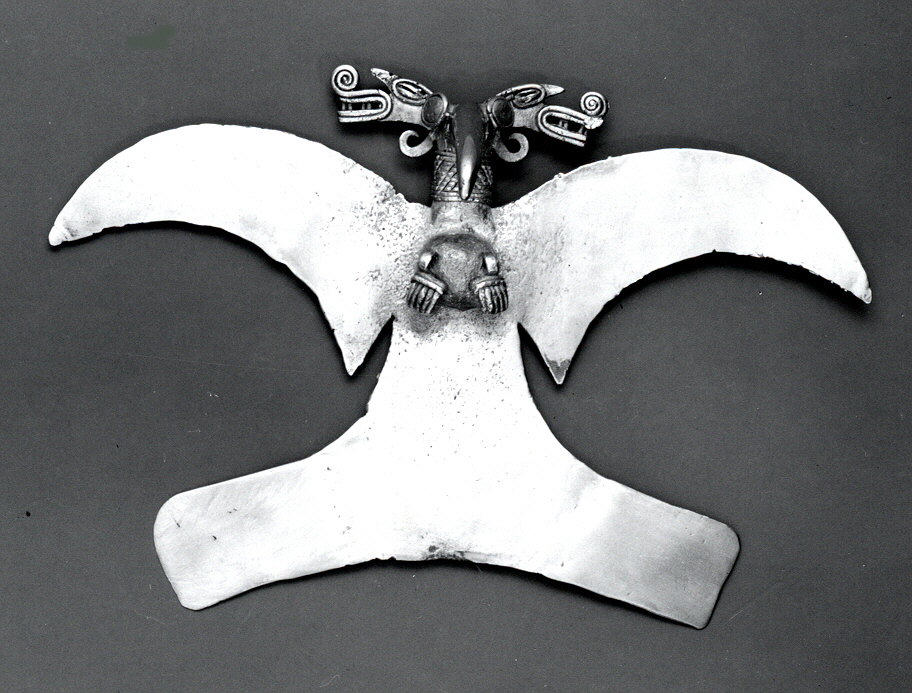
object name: pendant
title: Eagle Pendant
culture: veraguas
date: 1001-1600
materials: gold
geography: panama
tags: eagles